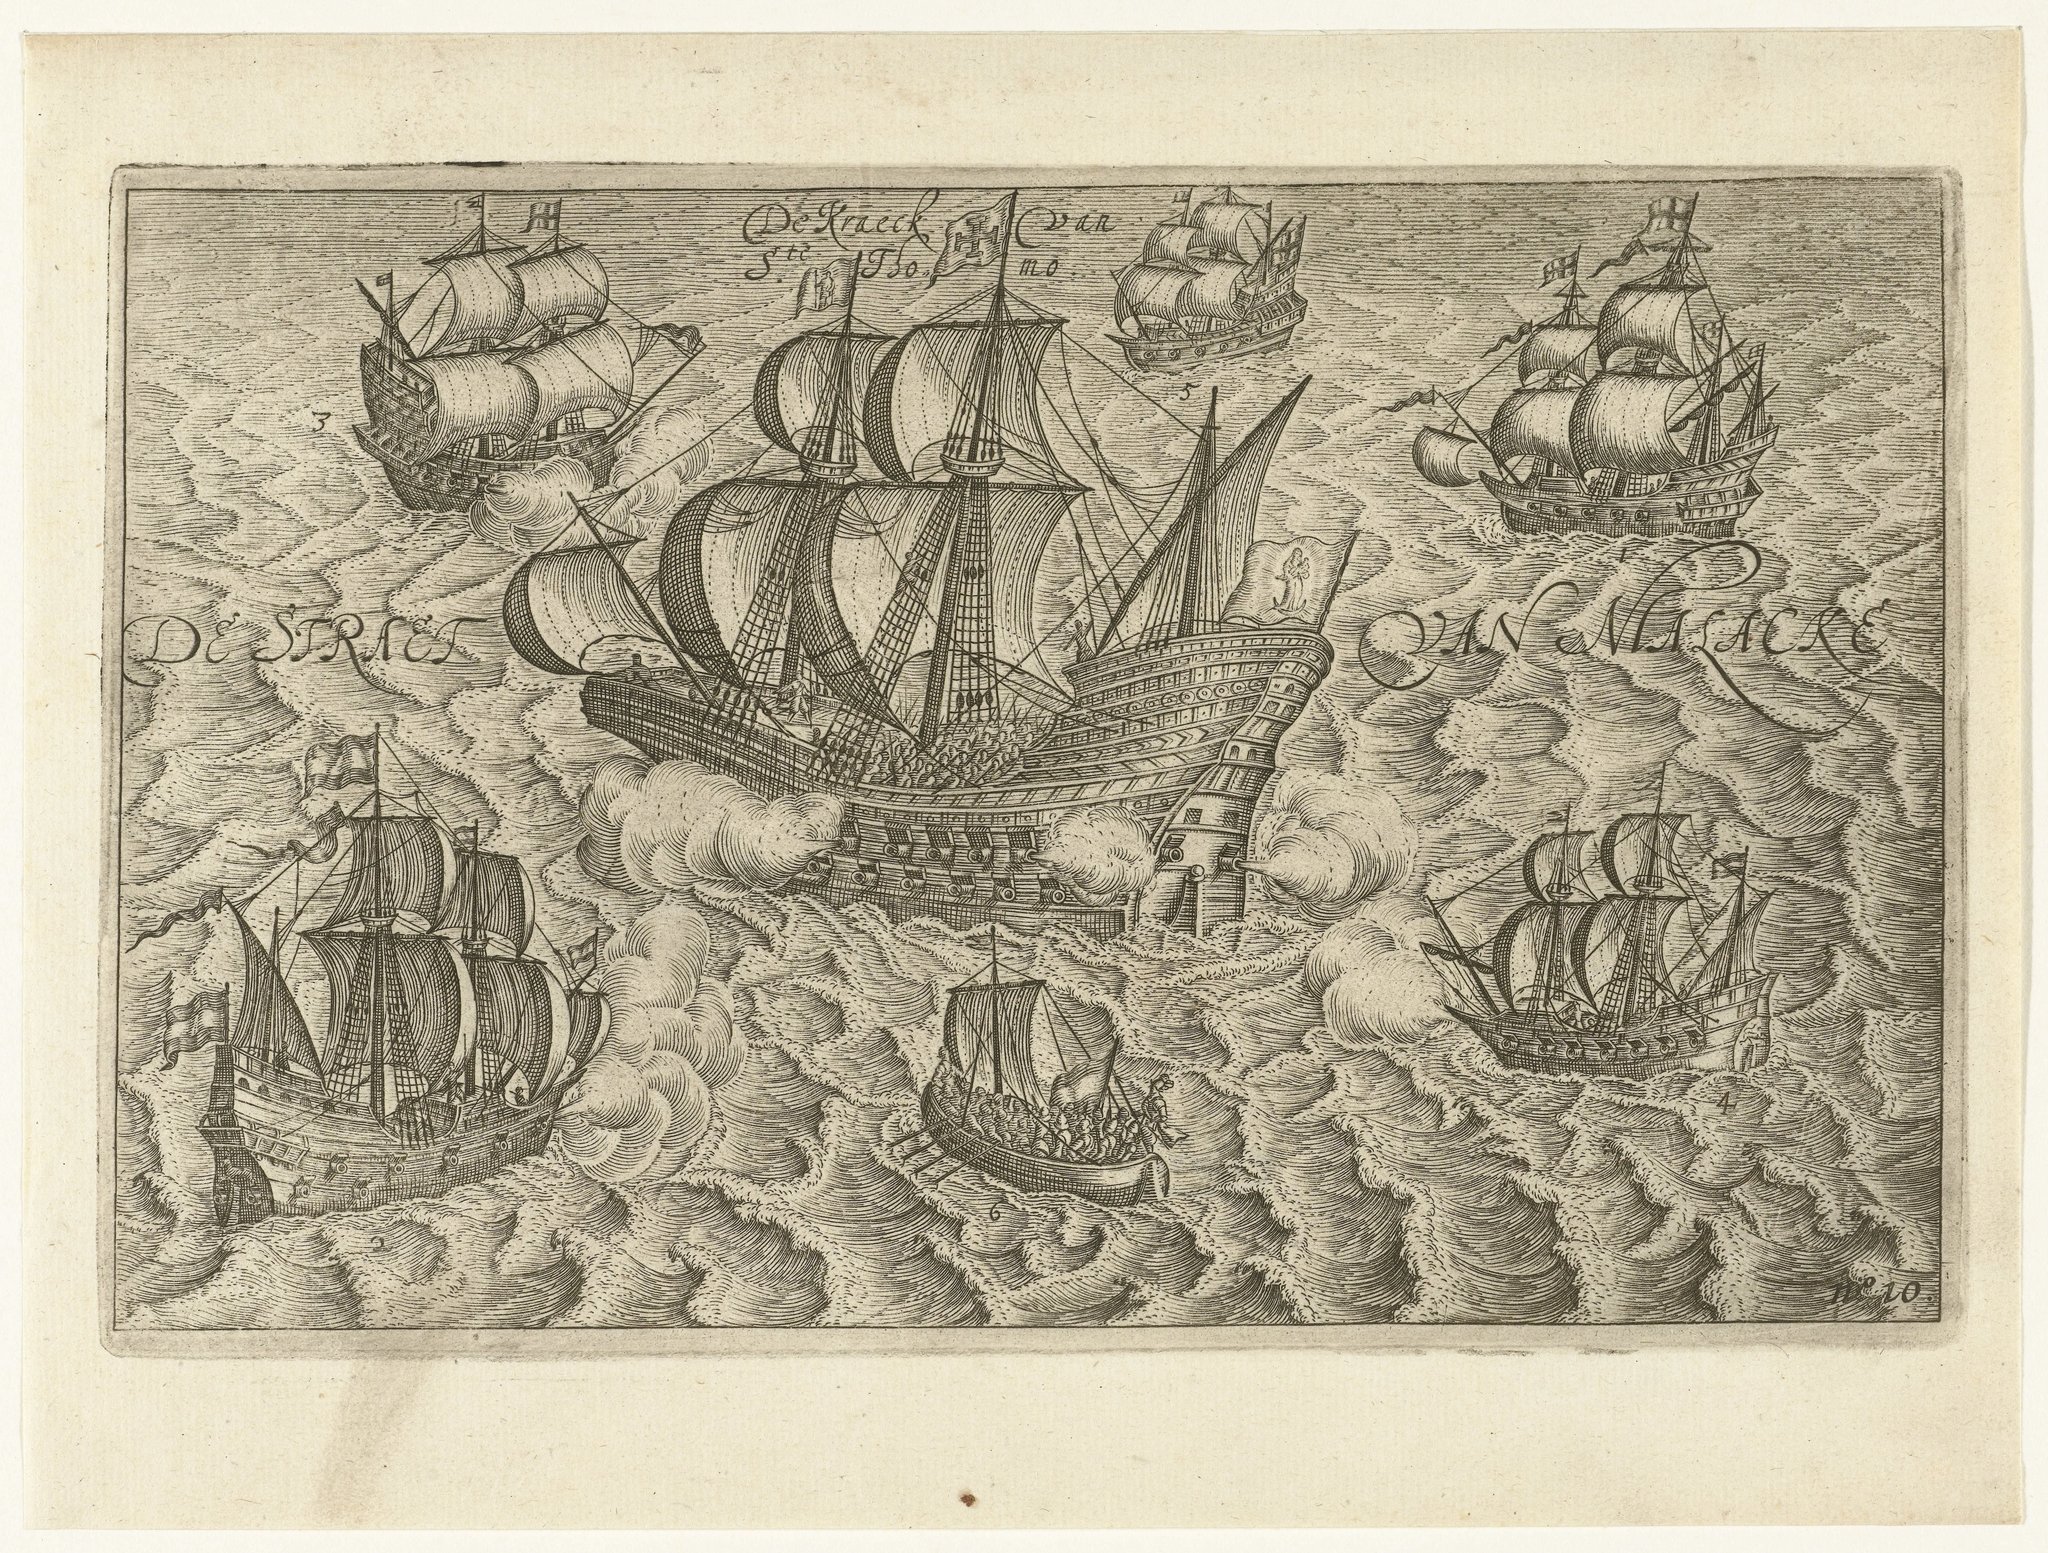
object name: print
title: De verovering van de Portugese kraak St. Thomé, 1602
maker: floris balthasarsz. van berckenrode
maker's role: print maker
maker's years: 1562-1616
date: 1603-1605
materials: paper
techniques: engraving, etching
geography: northern netherlands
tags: antwerp, bergen op zoom, battle (+ naval force), landscapes in tropical and sub-tropical regions, exploration, expedition, voyage of discovery, indonesia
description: Gebruikt als illustratie eerst in: J. van Spilbergen, t'Historiael iournael, van tghene ghepasseert is van weghen drie schepen (...) onder tbeleyt van Ioris van Speilberghen generael, anno 1601 (...) tot in t'eylant Celon, Floris Balthasars, Delft, 1605. In deze staat gebruikt als illustratie in: 't Historiael Journael, van tghene ghepasseert is van weghen drie Schepen ghenaemt den Ram, Schaep, ende het lam, ghevaren uyt Zeelandt, van der Stadt Camp-Vere, naer d'Oost-Indien, onder 't beleyt van den heer Admirael Joris van Splibergen, gedaen in de Jaren 1601. 1602. 1603. ende 1604. Opgenomen in: I. Commelin, Begin ende voortgangh, van de Vereenighde Nederlantsche Geoctroyeerde Oost-Indische Compagnie, J. Janssonius, Amsterdam 1646. Genummerd: No. 10.